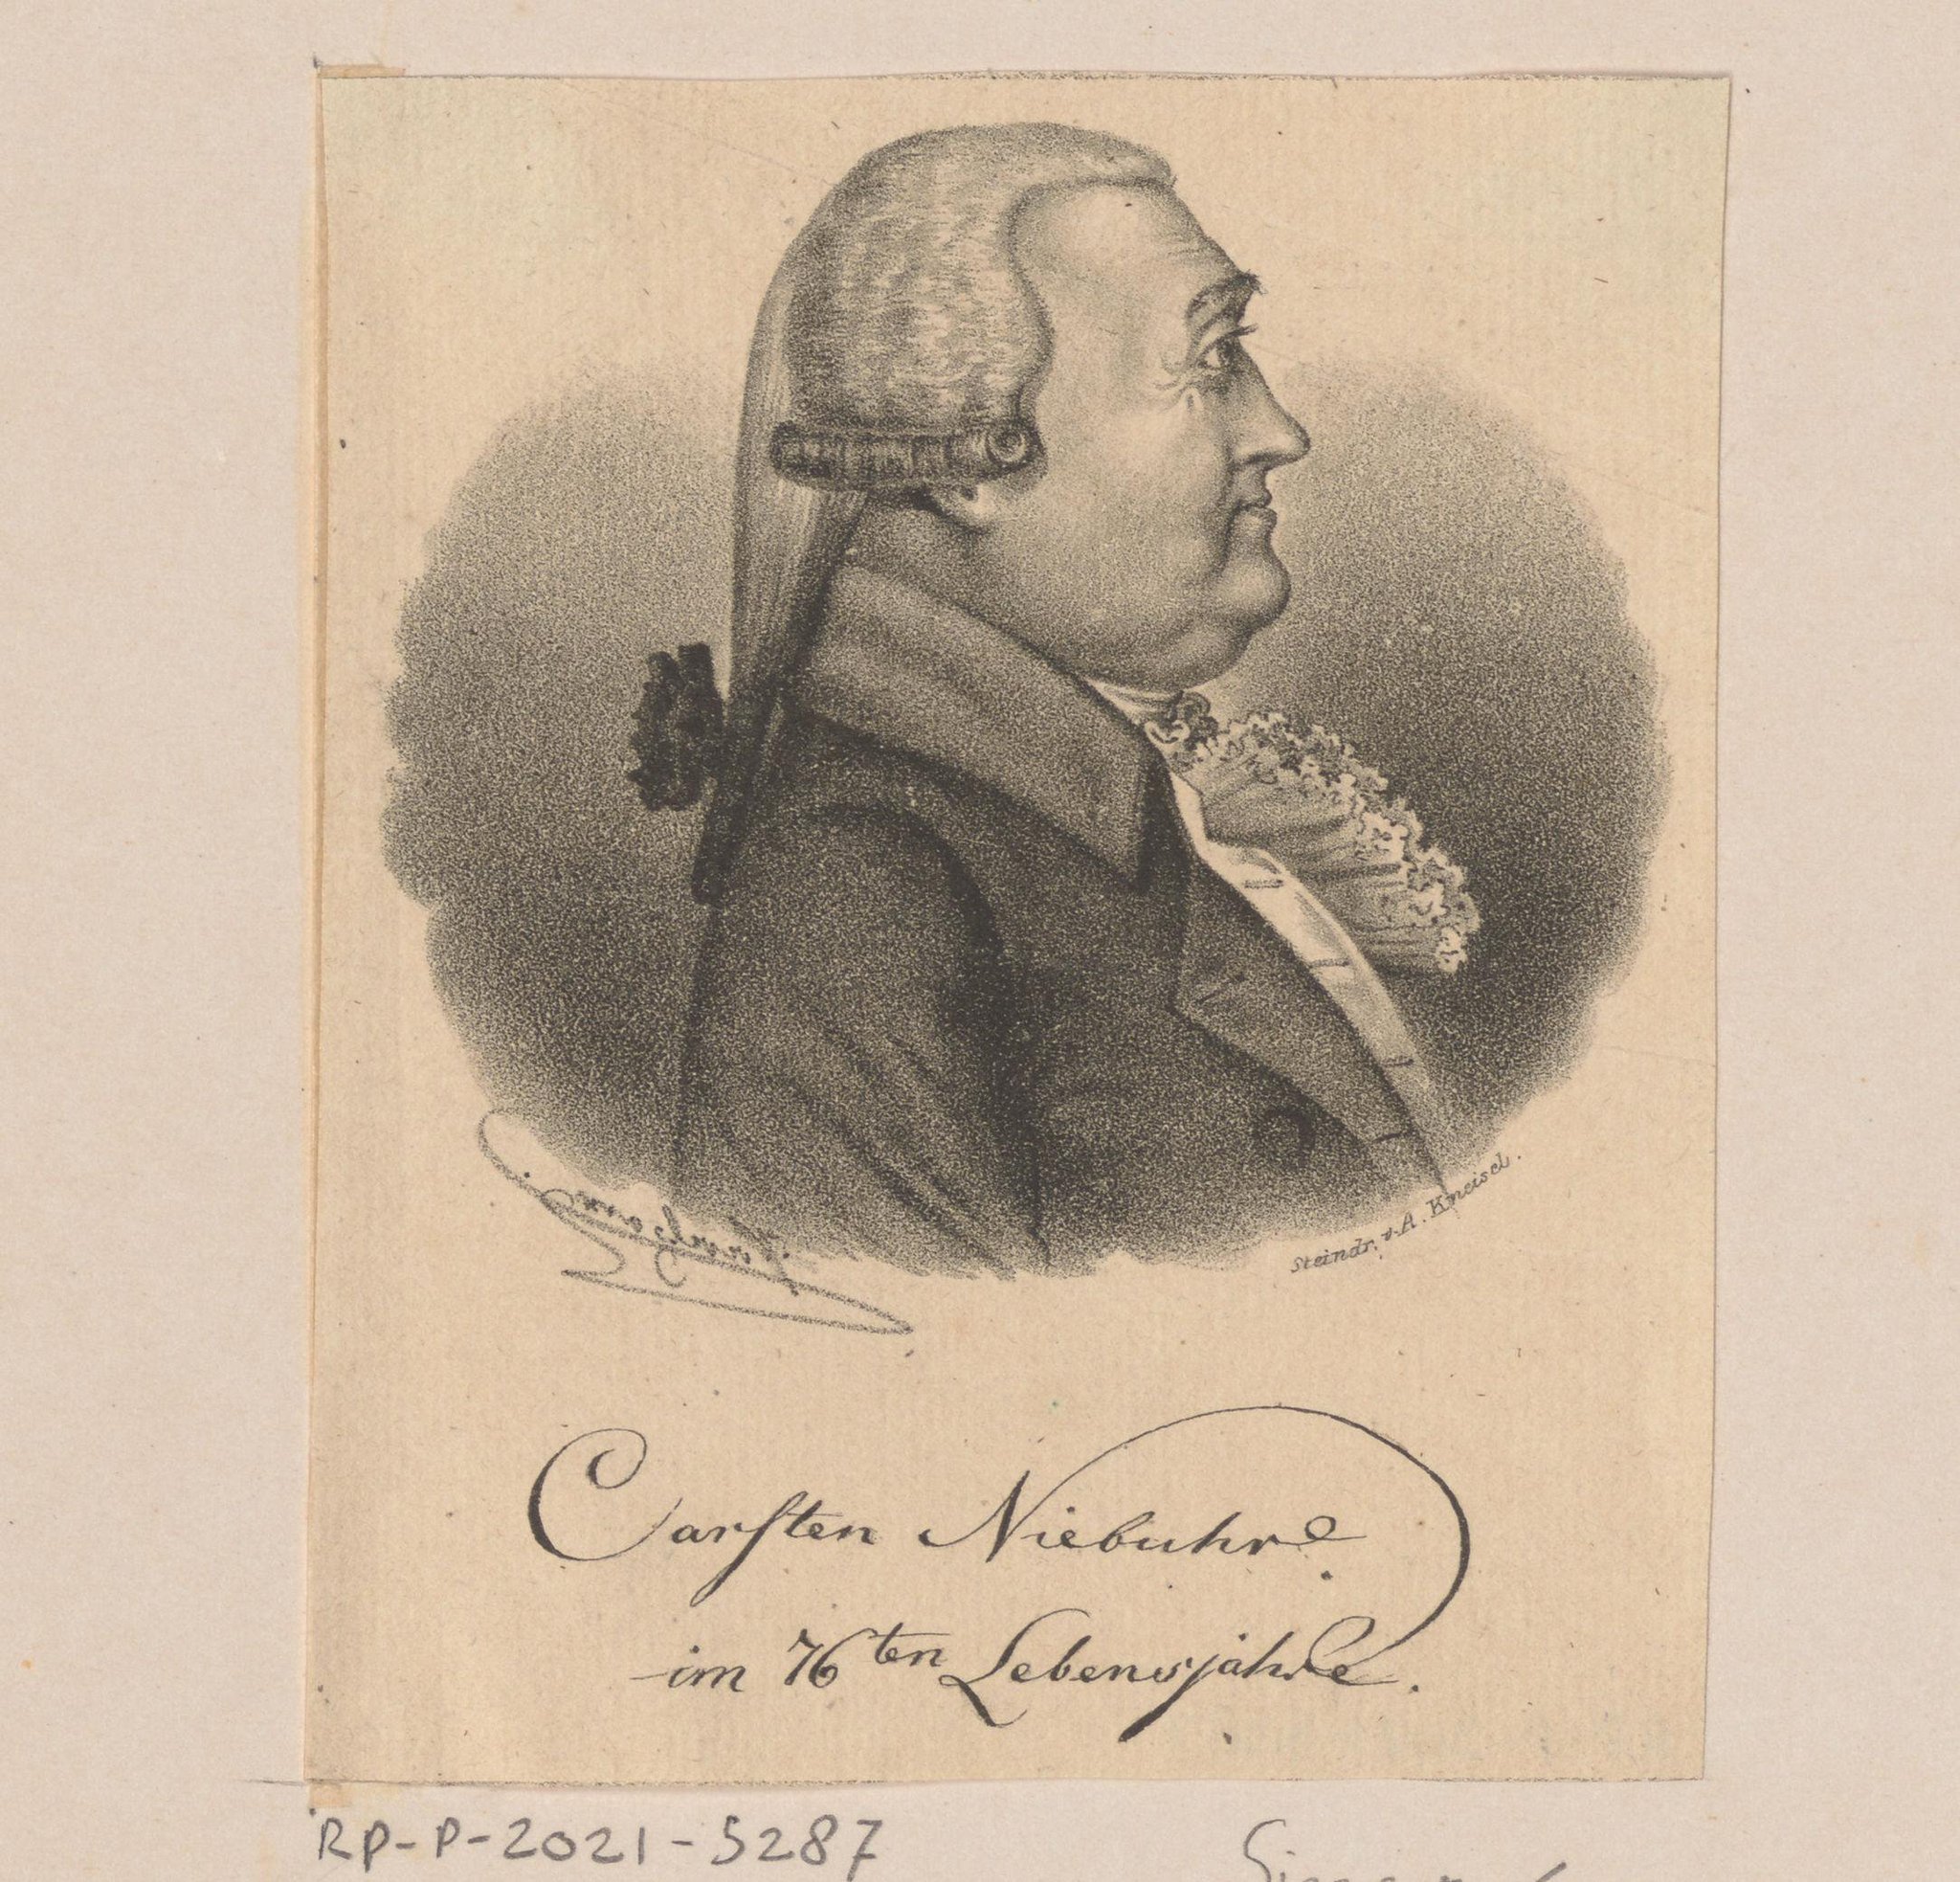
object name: print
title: Portret van Carsten Niebuhr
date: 1809-1855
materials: paper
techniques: lithograph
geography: leipzig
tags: historical persons, portrait of a writer